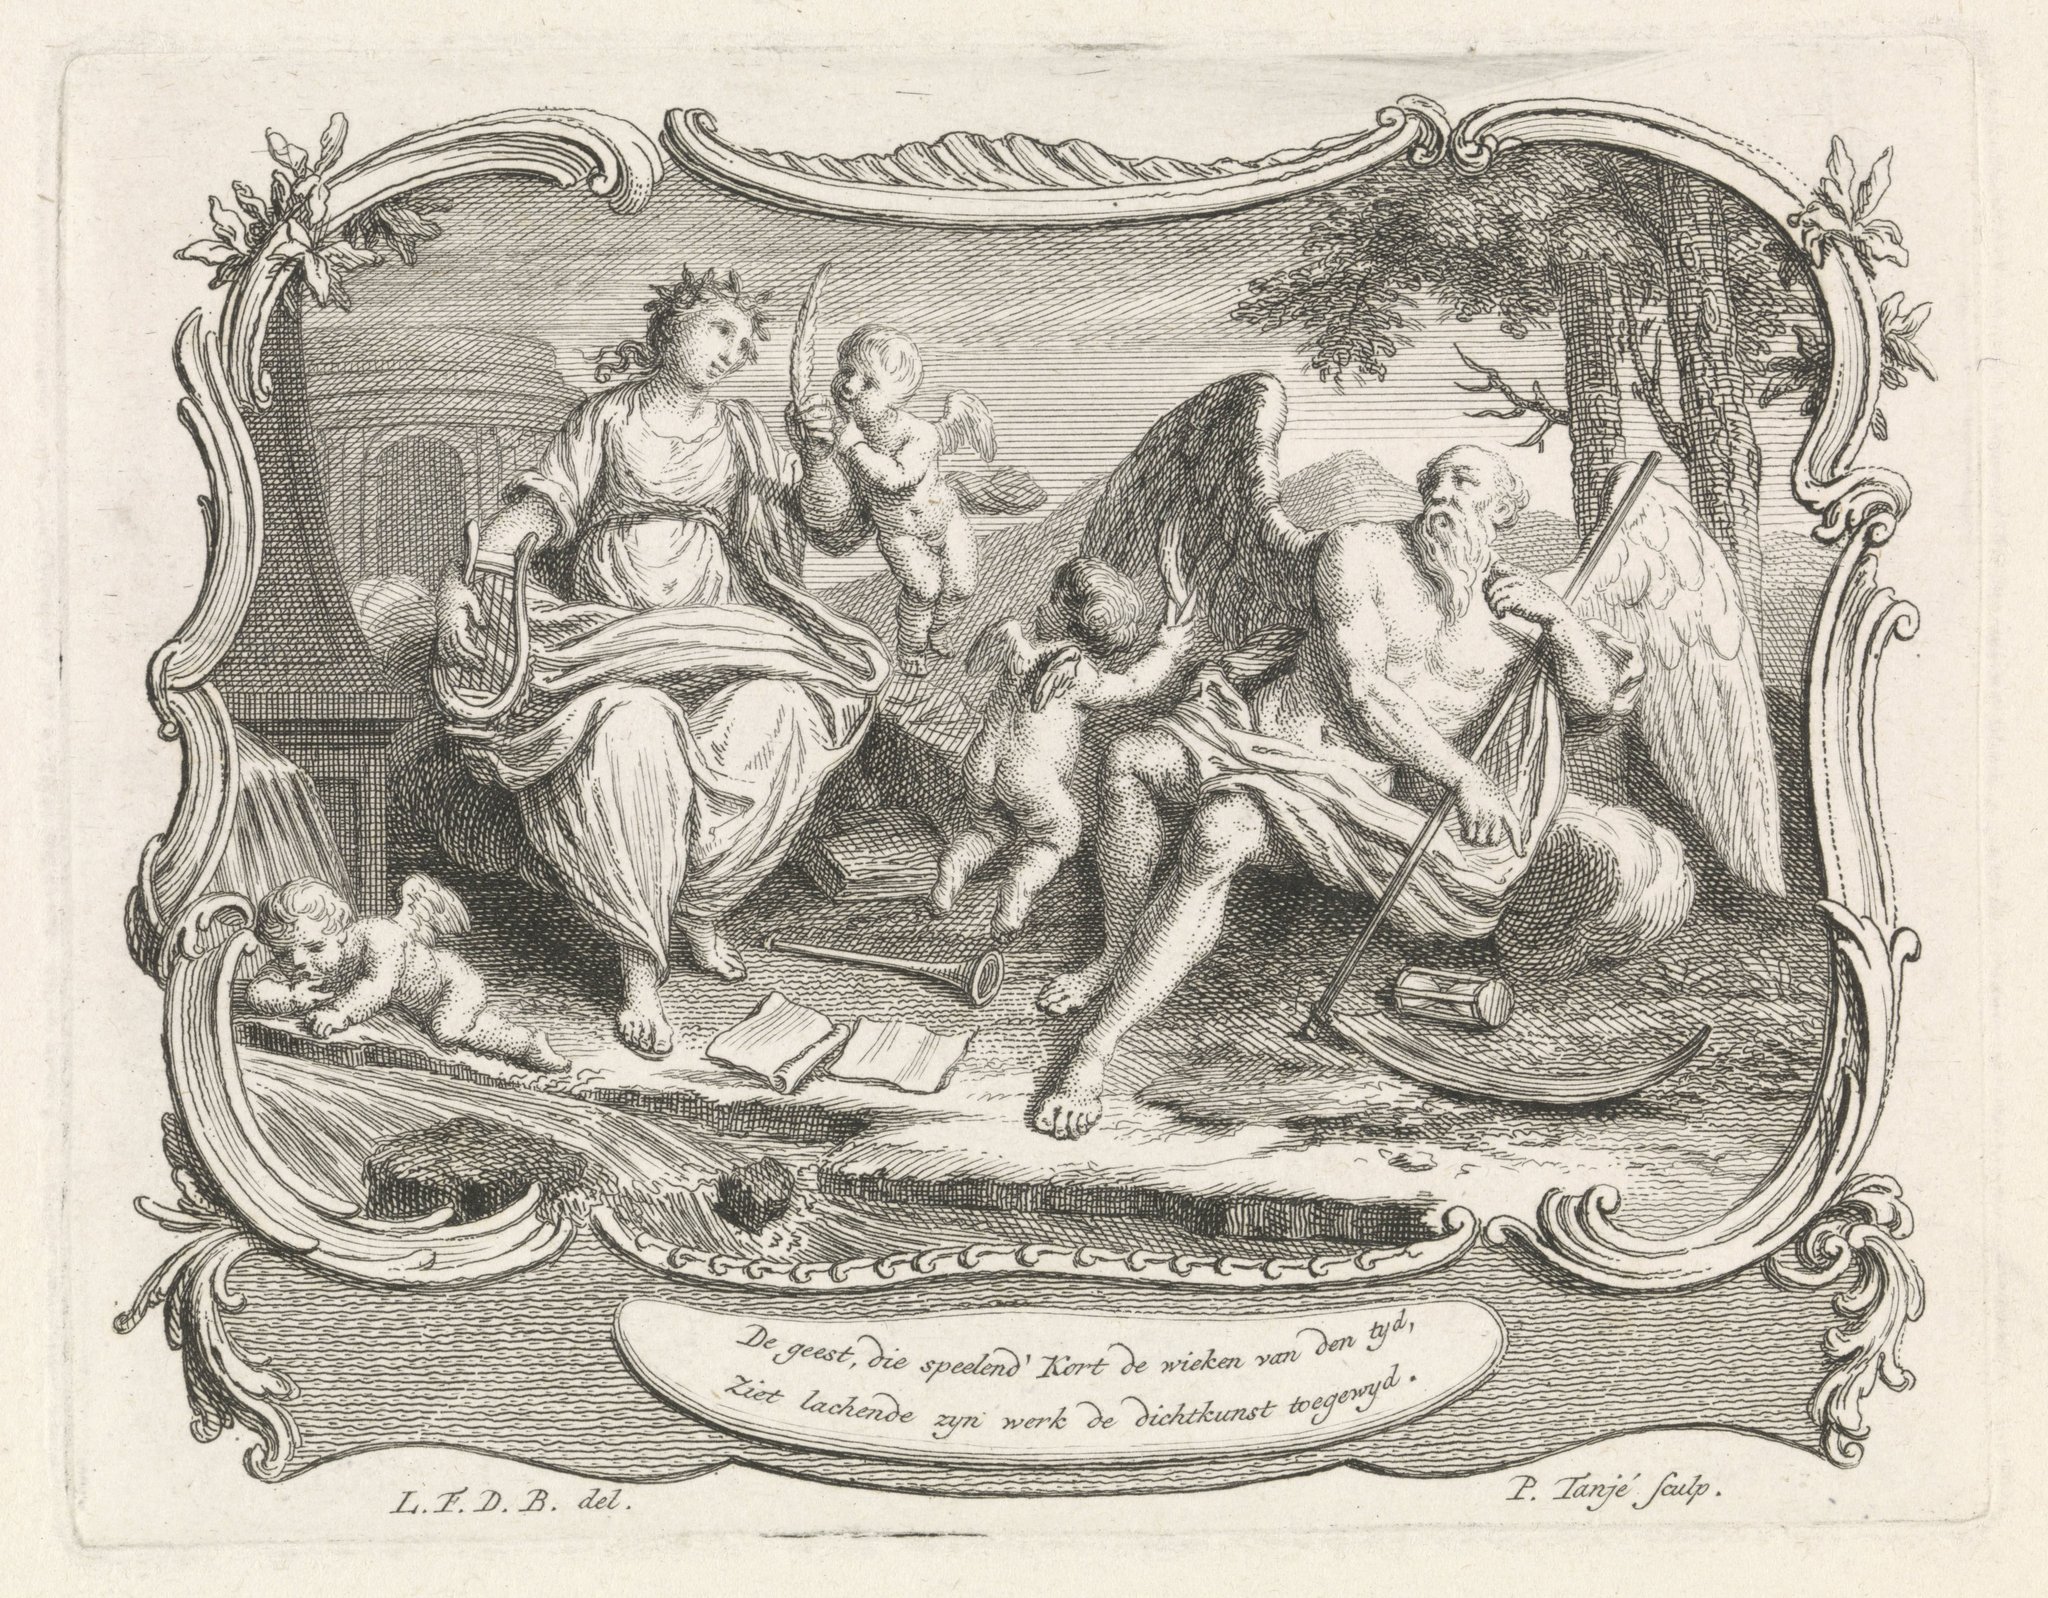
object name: print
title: Dichtkunst en de Tijd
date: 1716-1761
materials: paper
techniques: engraving, etching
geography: amsterdam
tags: symbolic representations, allegories and emblems ~ poetry; 'poesia' (ripa), cupids: 'amores', 'amoretti', 'putti', father time, man with wings and scythe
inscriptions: collector's mark: Lugt 240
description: De Dichtkunst, een vrouw met een lier in haar handen, zit naast Vader Tijd. Een putto drinkt uit de stroom van inspiratie. De voorstelling is gevat in een ornamenteel cartouche.